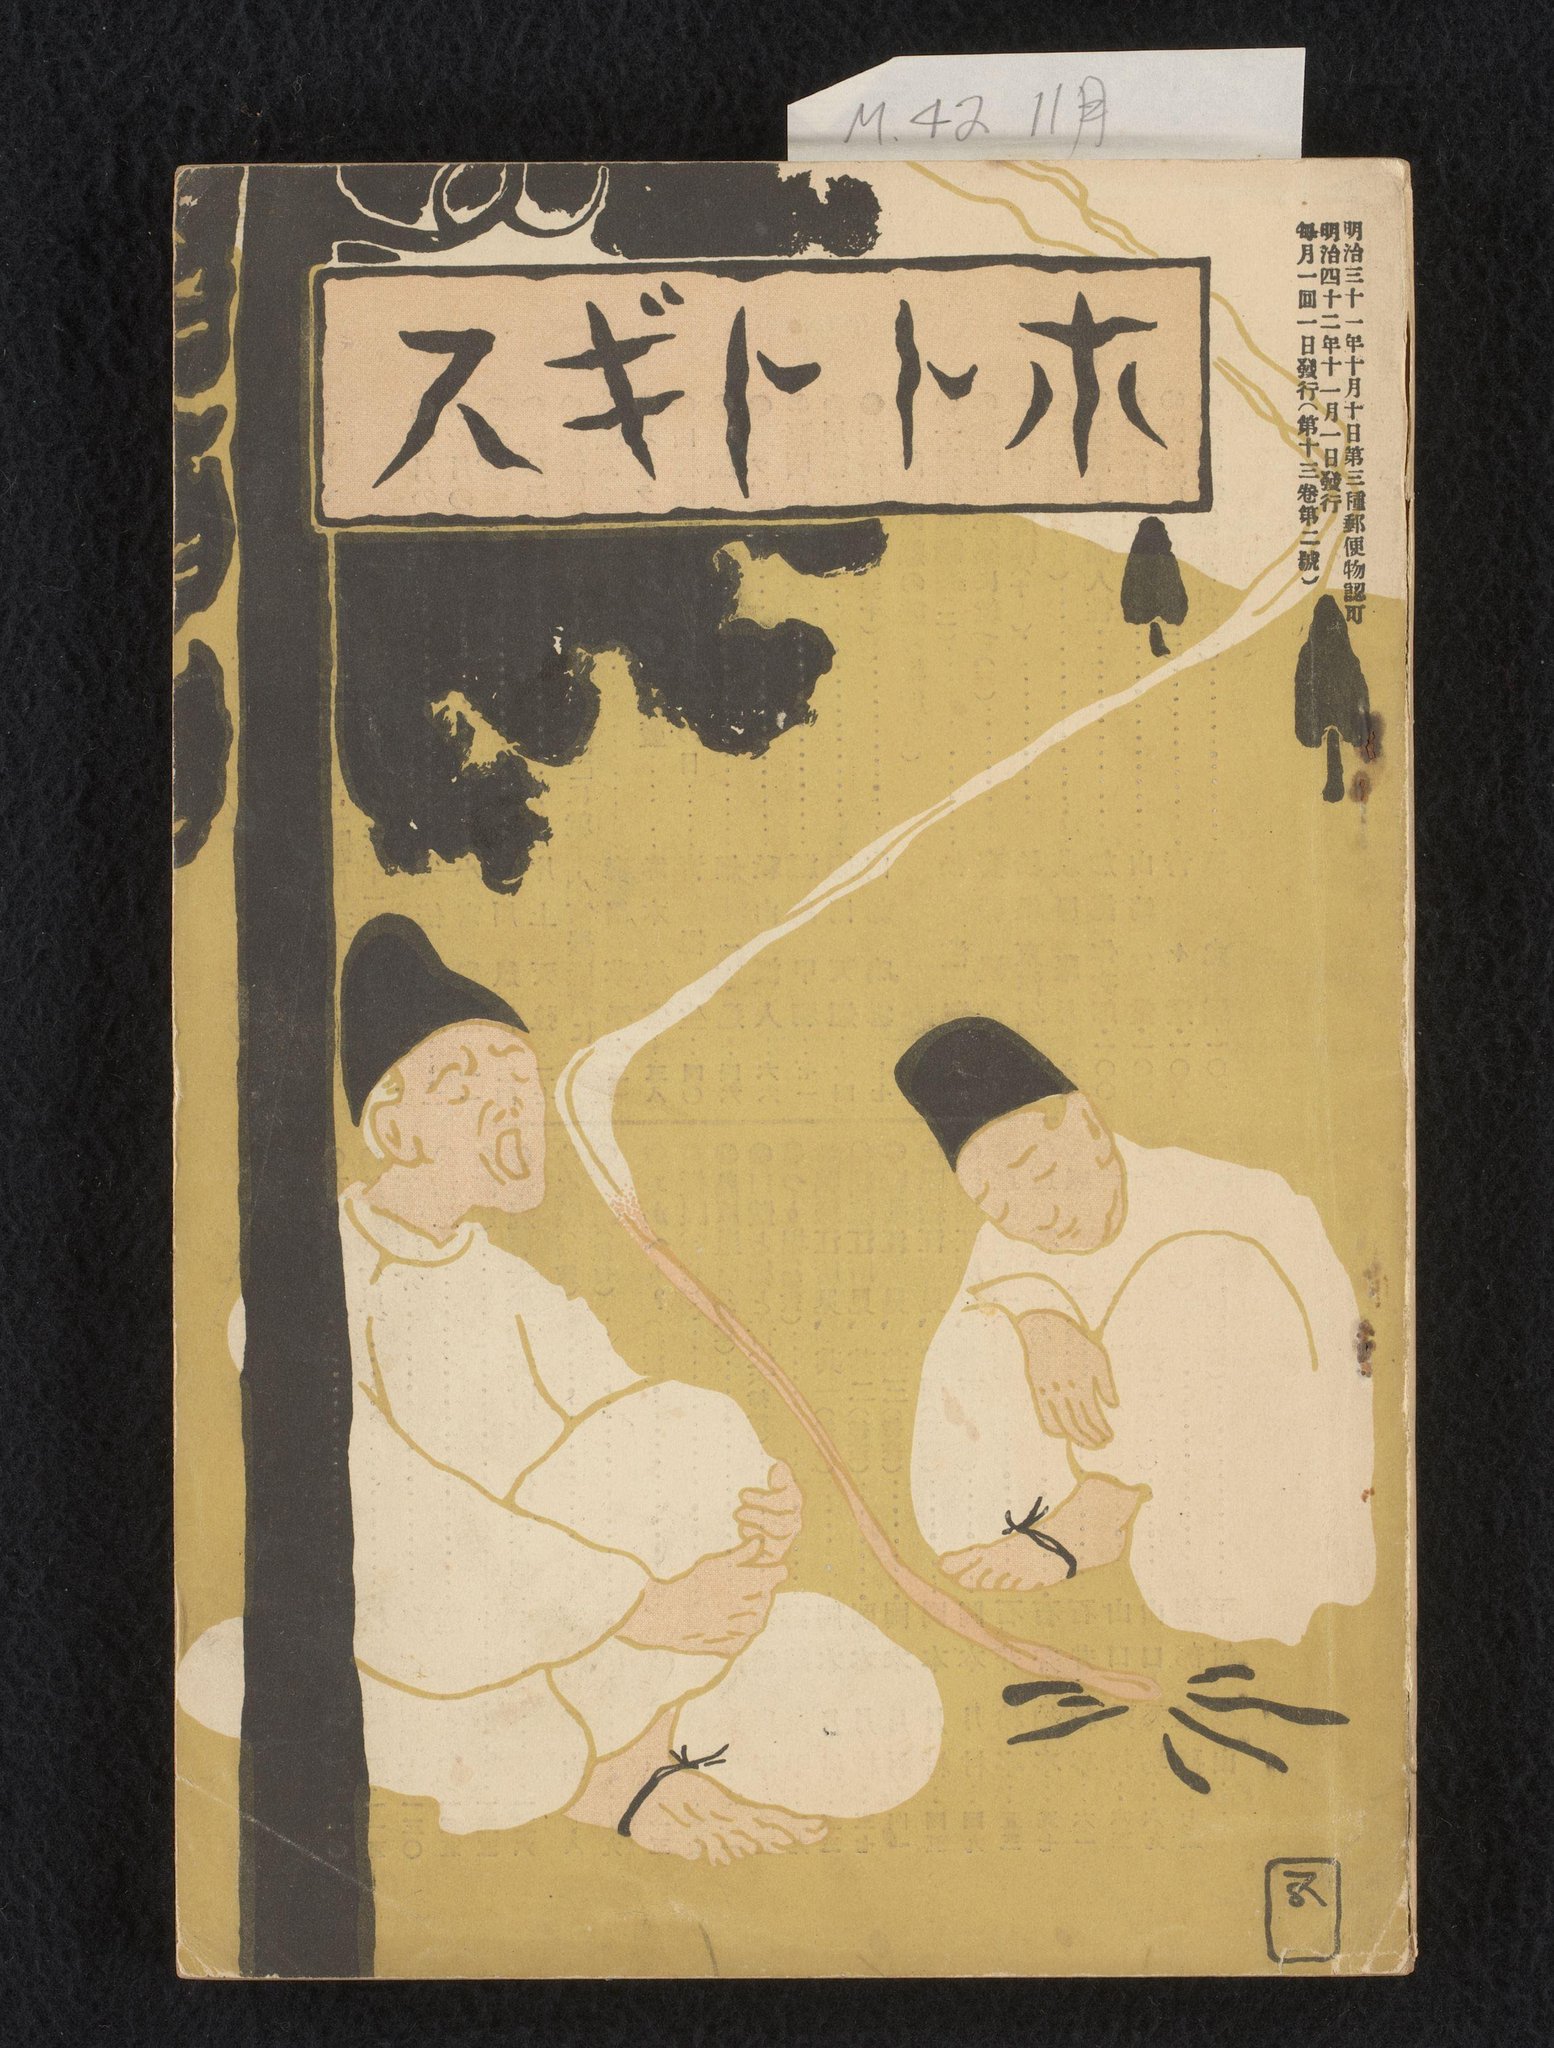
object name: magazine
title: November 1909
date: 1909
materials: paper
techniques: woodcut, letterpress printing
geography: japan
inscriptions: date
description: Ontwerp titelplaat: Hashiguchi Goyô. Overige illustraties: Shimomura Izan (1), Miyazaki Yohei (50, Okamoto Gesson (5), Yamaguchi Shûbô (2), Watabe Koson (1) en Ishii Hakutei (3). Ontwerp achterkant illustratie: Shimomura Izan.